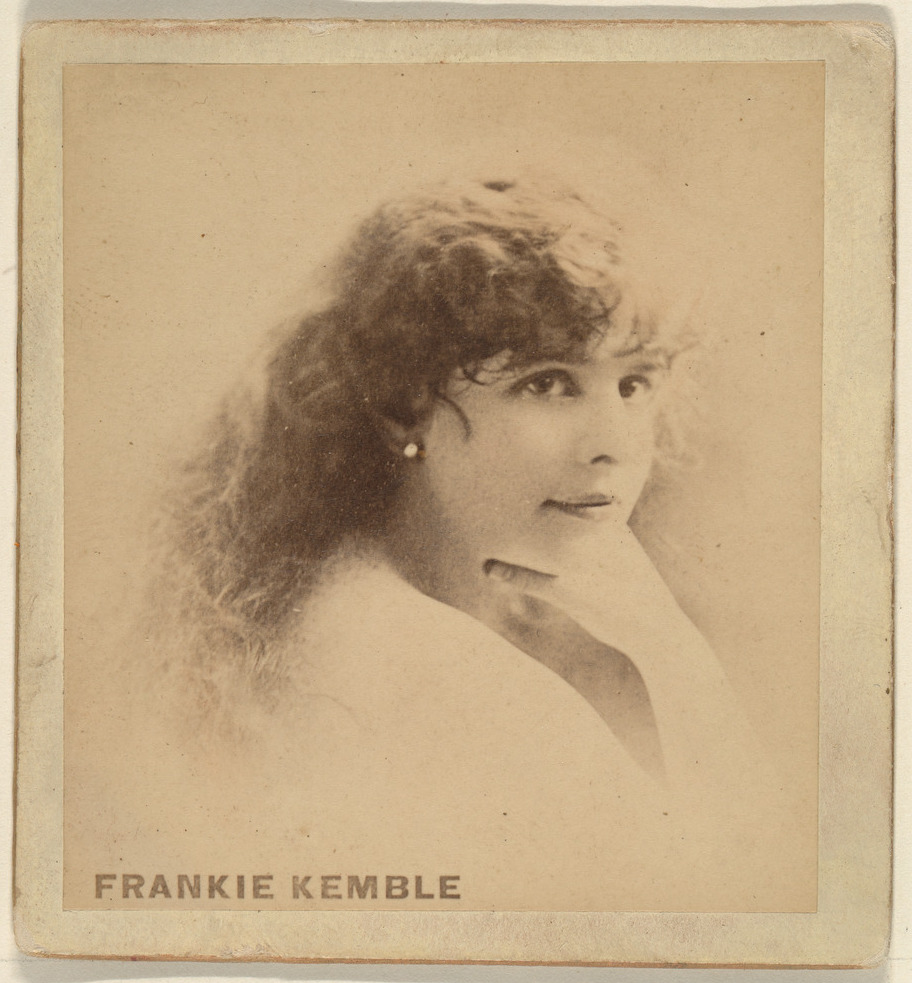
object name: photograph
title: Frankie Kemble, from the Actresses series (N246), Type 2, issued by Kinney Brothers to promote Sporting Extra Cigarettes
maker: kinney brothers tobacco company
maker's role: publisher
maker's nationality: american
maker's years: 1869-2011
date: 1890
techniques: albumen silver print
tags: portraits,women,actresses